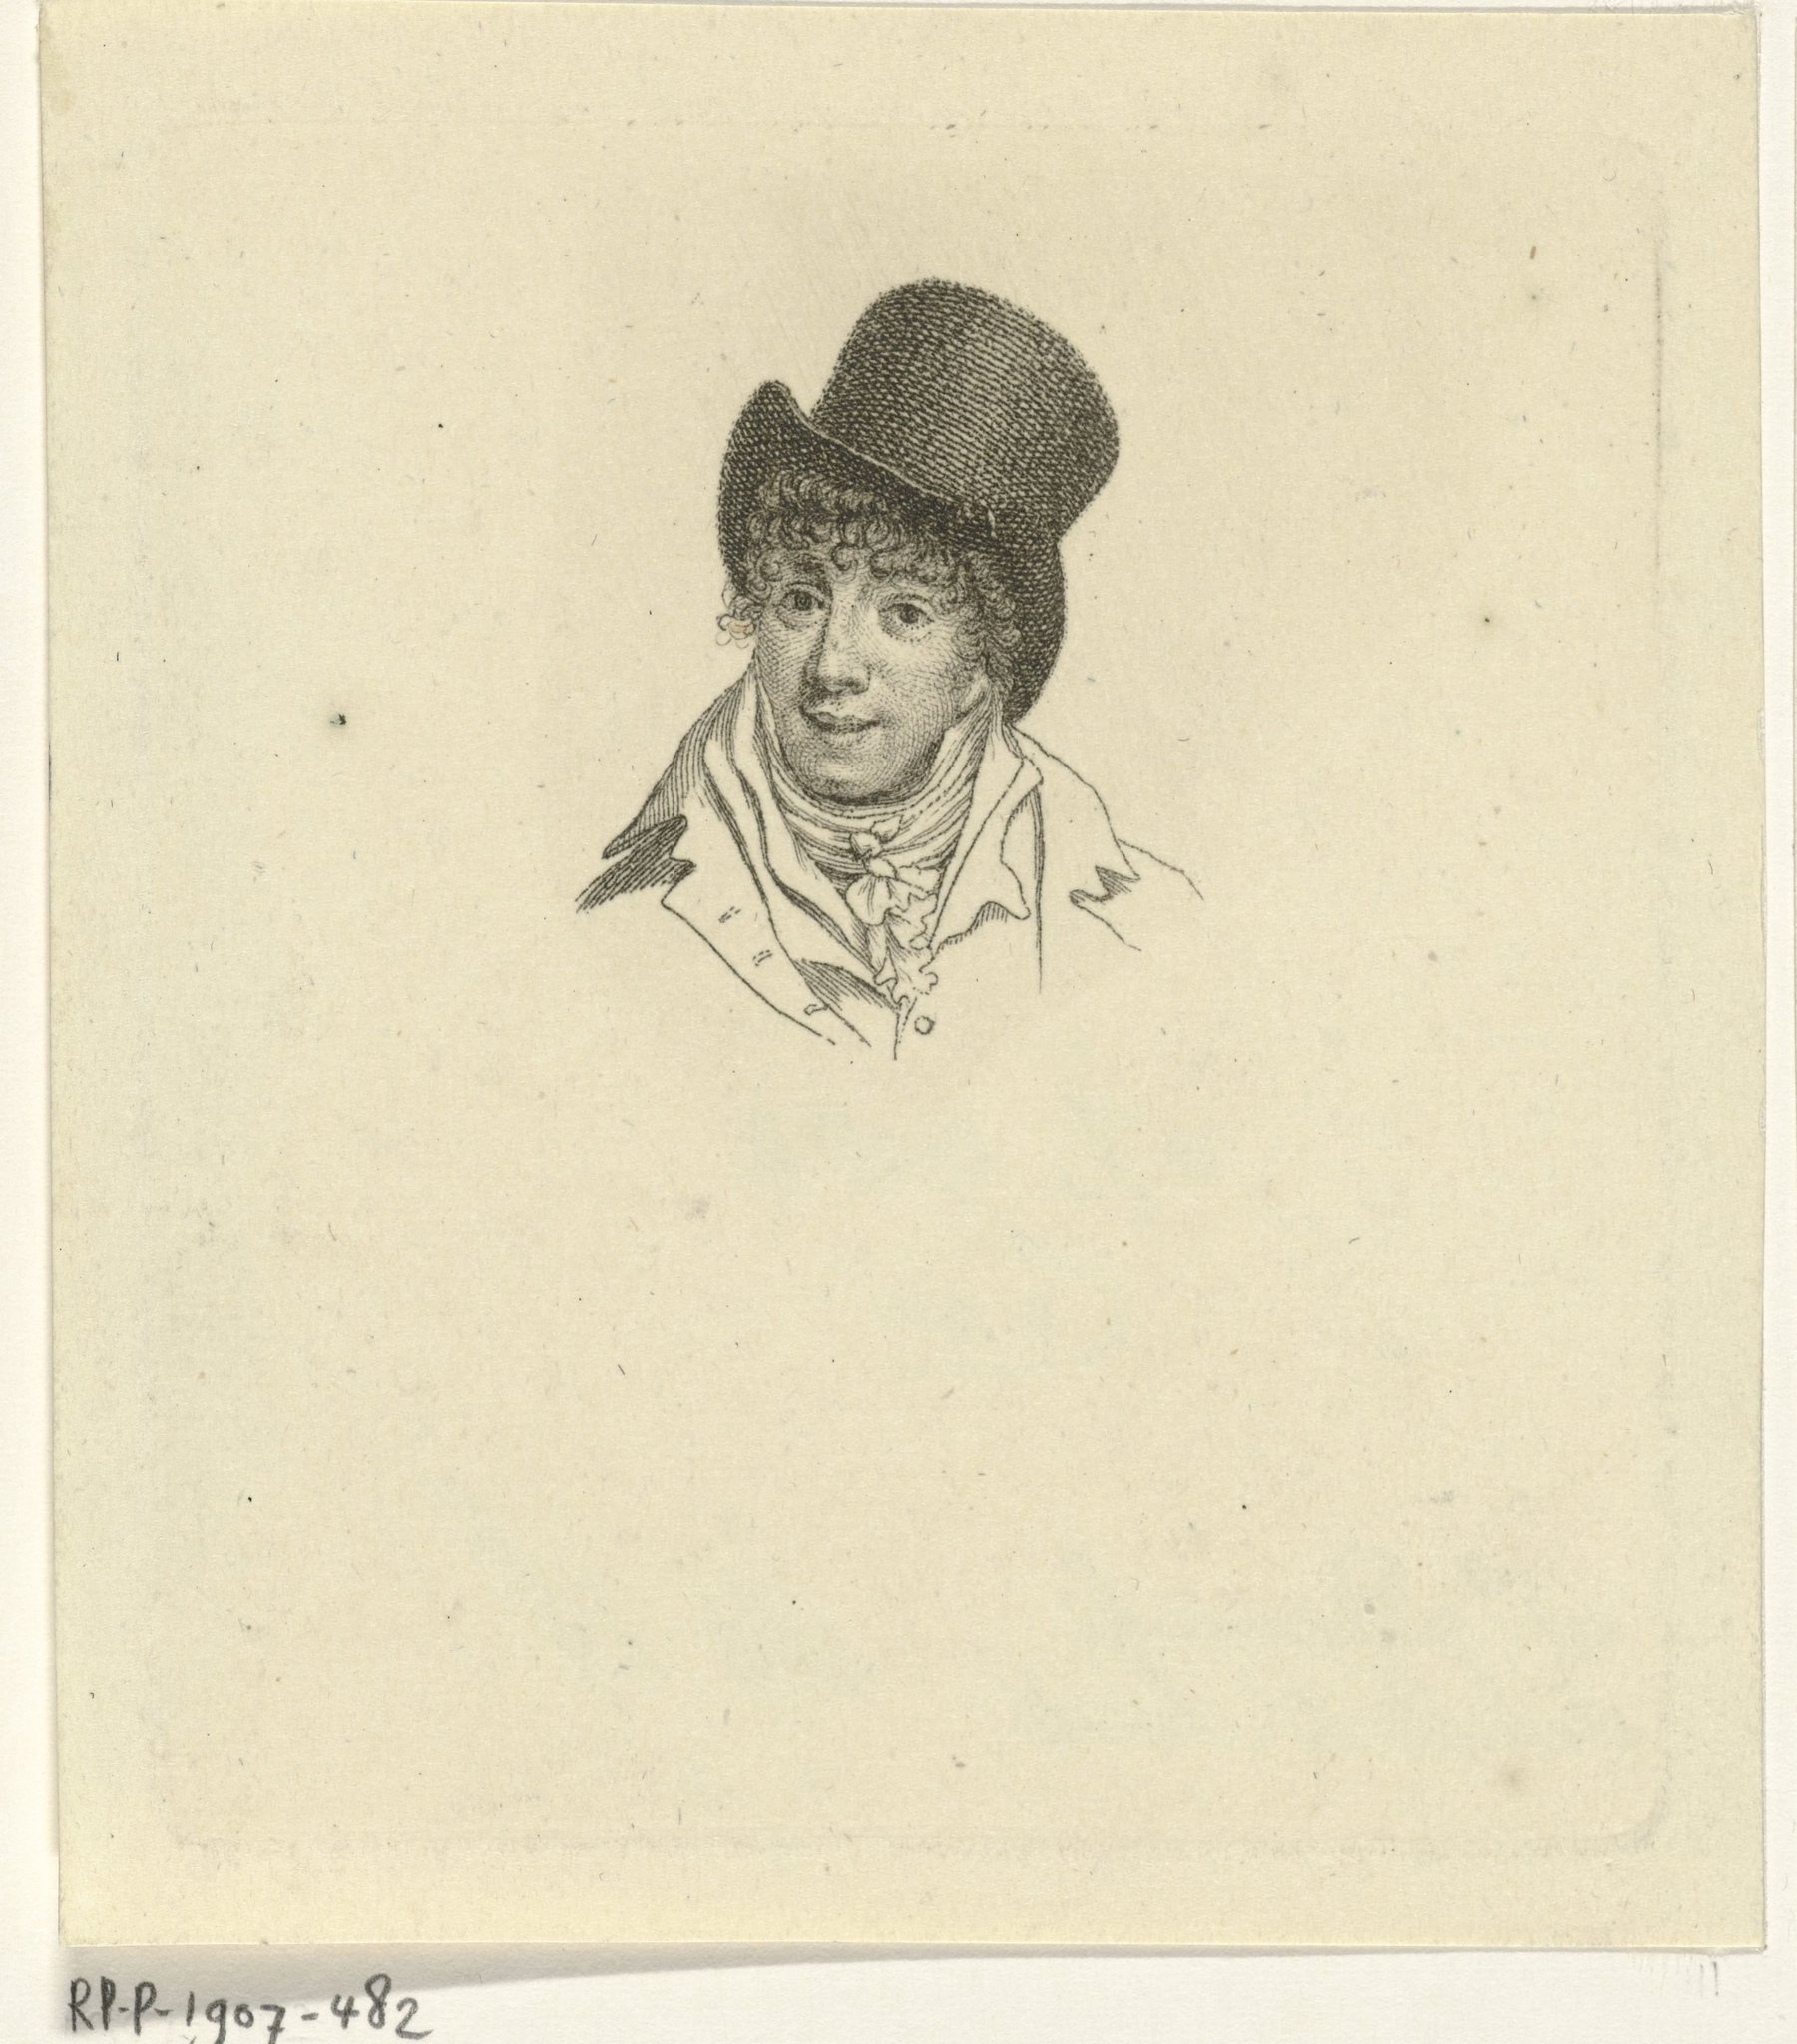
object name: print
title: Portret van Thomas Ferdinand Joseph Bianchi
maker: jacob ernst marcus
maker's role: draughtsman, print maker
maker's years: 1774-1826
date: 1809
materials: paper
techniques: etching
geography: amsterdam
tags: amsterdam, painter, draughtsman, head-gear: hat (+ men's clothes)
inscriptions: inscription: ‘T.Bianchi/ Schilder te Amster.’, collector's mark: Lugt 2228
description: Latere staat van de gehele prent gebruikt in: Jacob Ernst Marcus, Etudes gravées. Amsterdam: S. de Grebber, 1826.